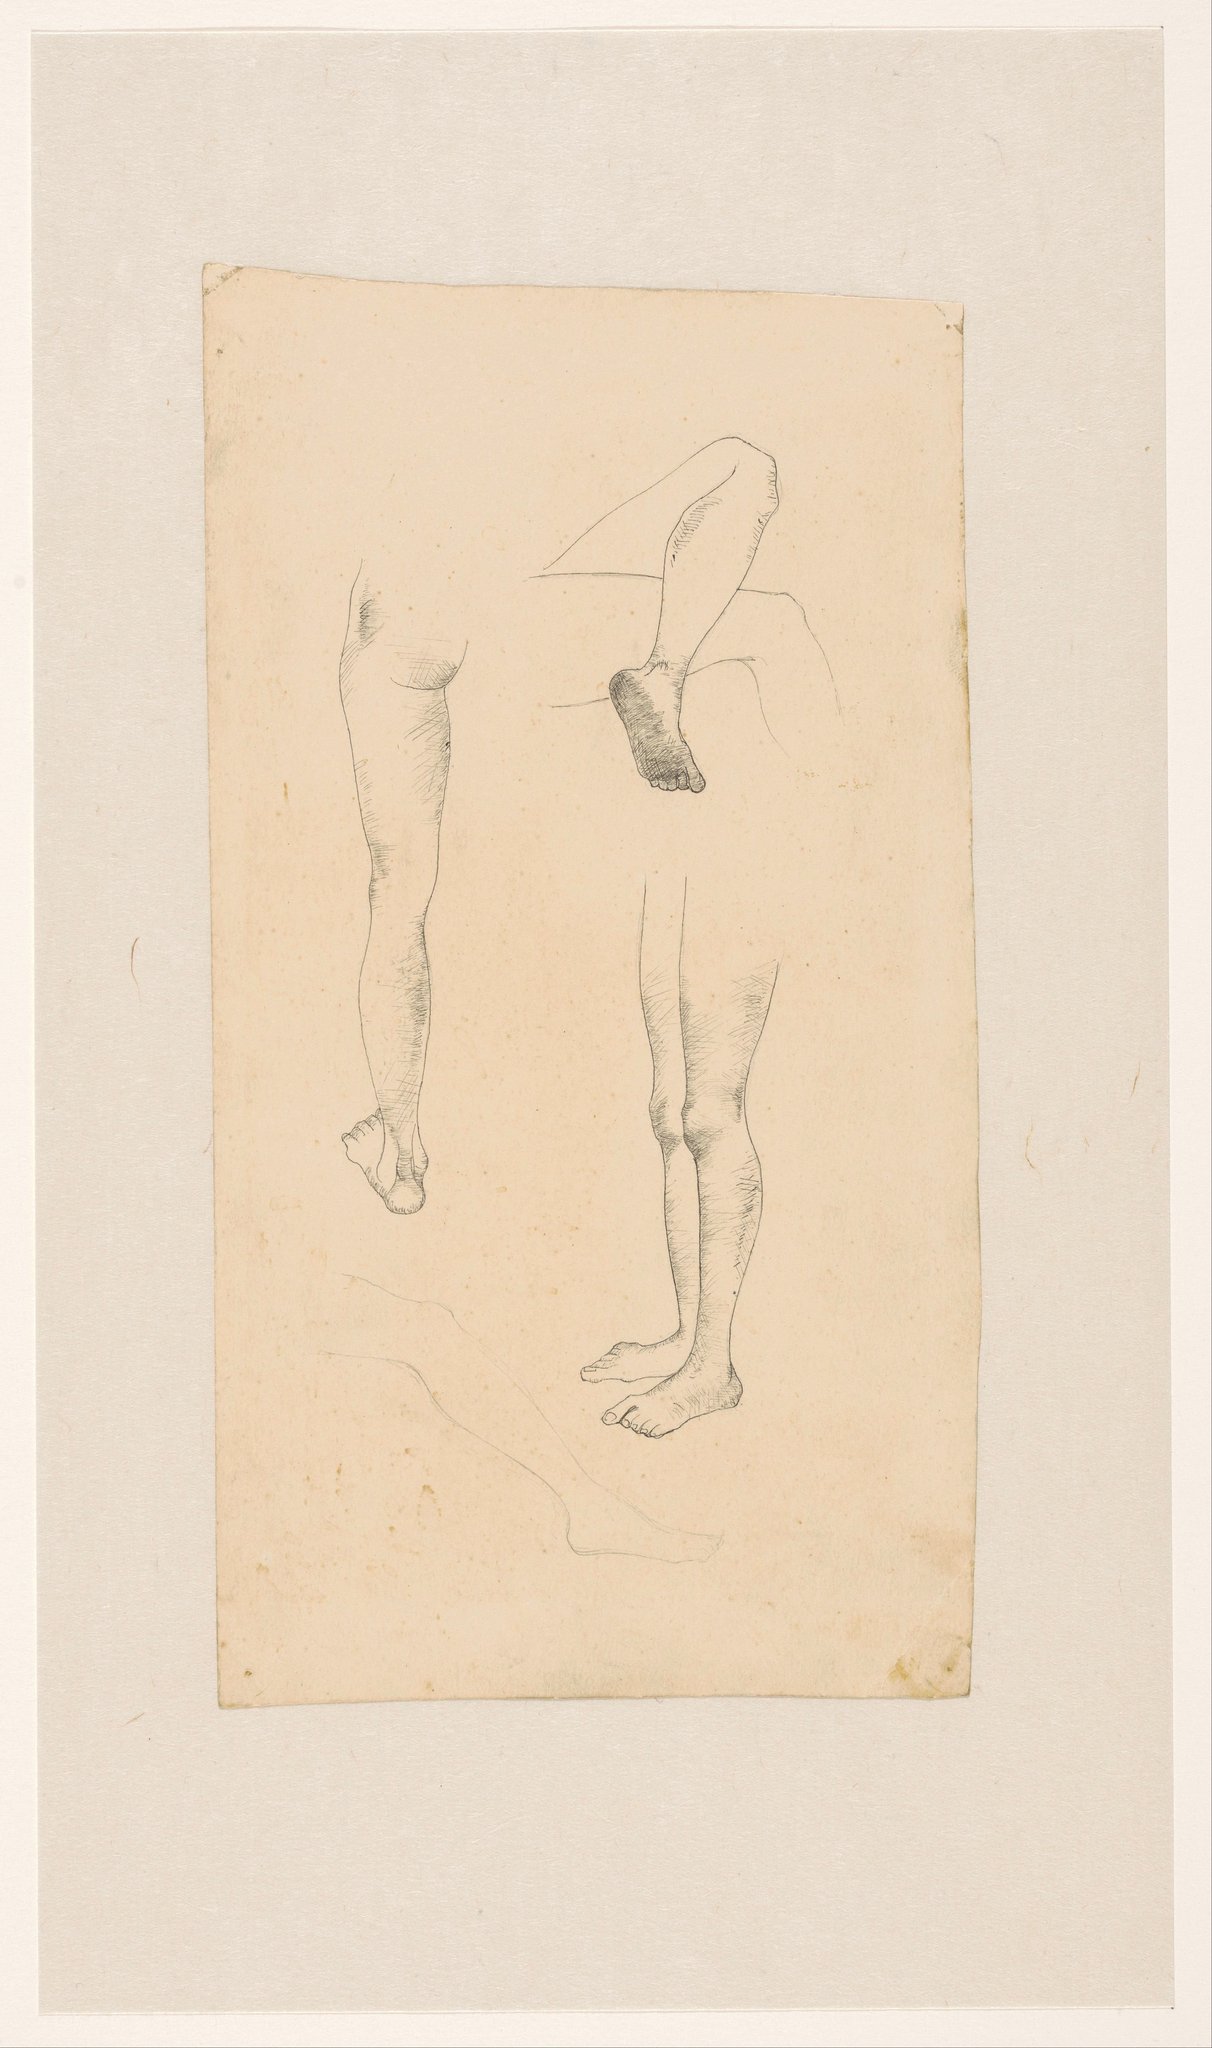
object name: drawing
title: Benen van een meisje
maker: jan mankes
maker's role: draughtsman, painter, print maker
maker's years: 1889-1920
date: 1899-1920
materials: ink, paper, pencil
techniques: pen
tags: legs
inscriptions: collector's mark: Lugt 2228